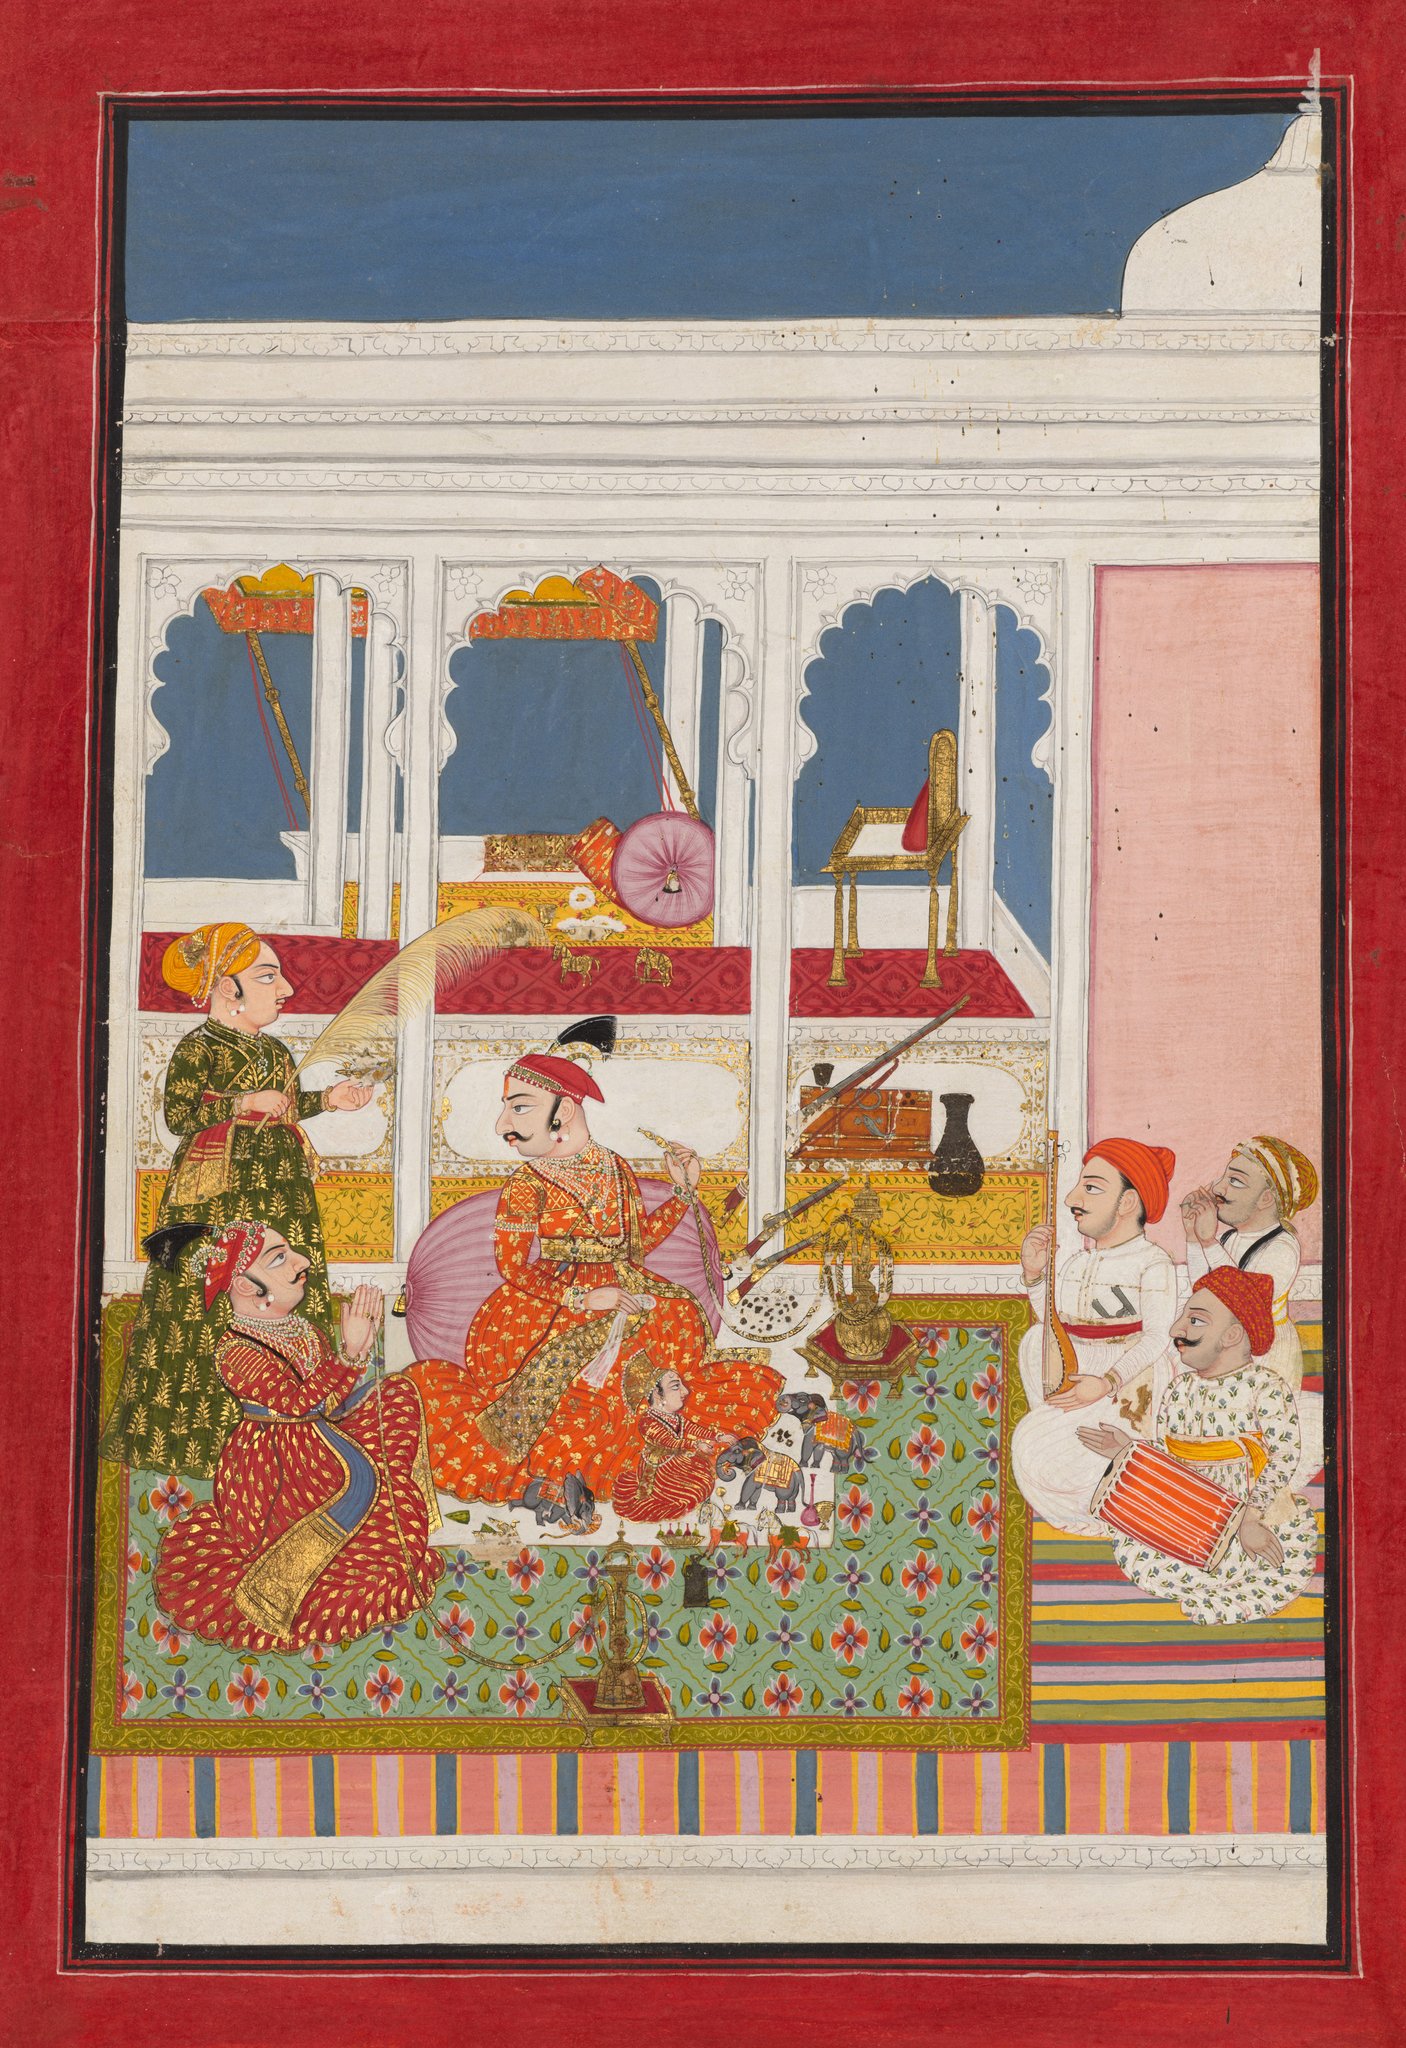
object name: painting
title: Maharaja Baghji with Courtiers and His Infant Son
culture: mewar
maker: ala bagas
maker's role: artist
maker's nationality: indian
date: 1750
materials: gold, ink, paper, silver, watercolor